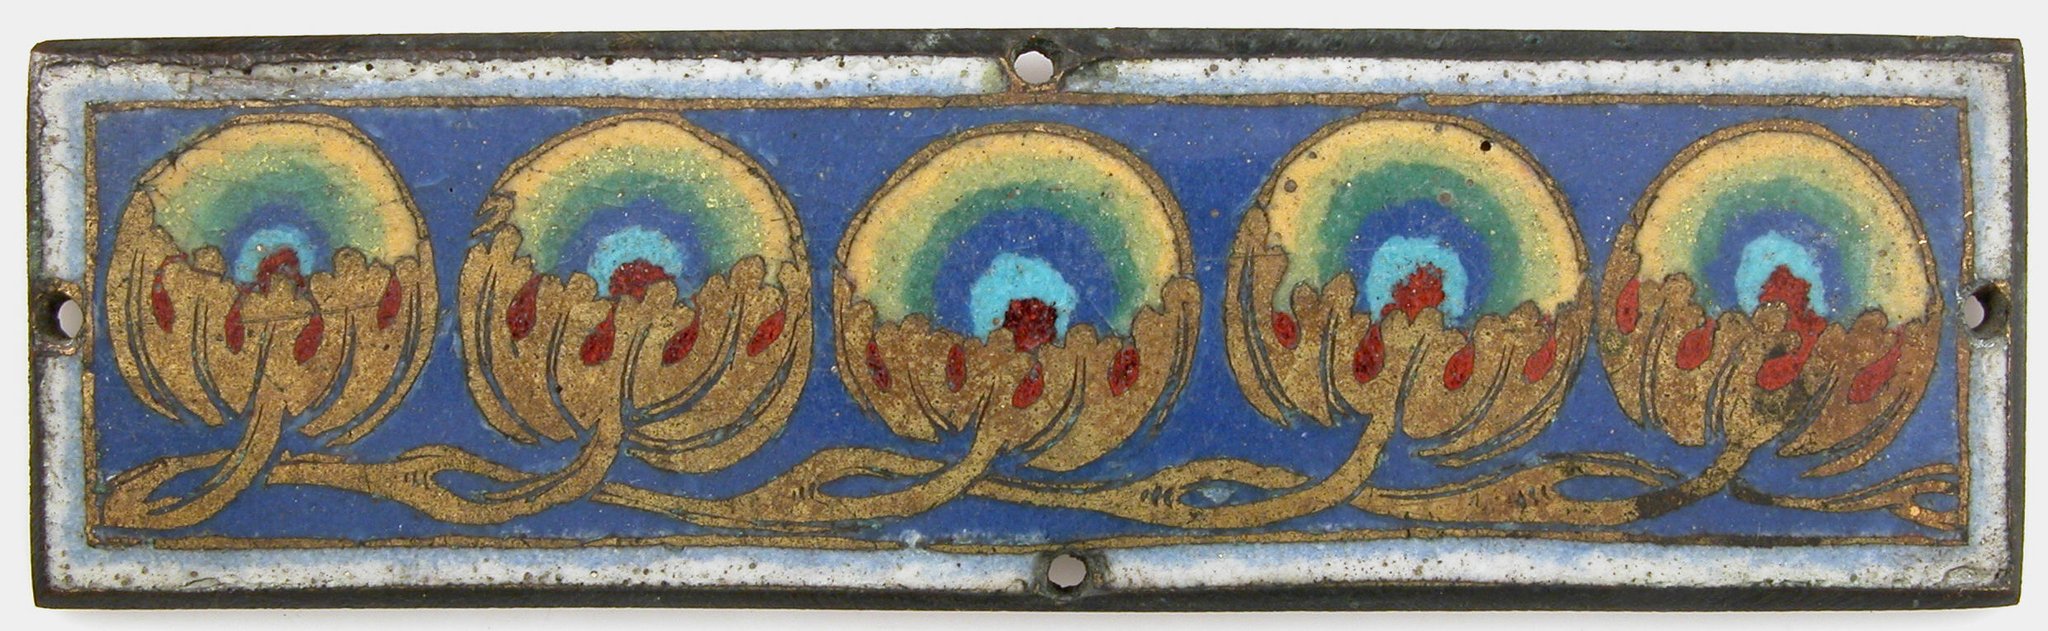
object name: plaque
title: Plaque from a Reliquary Shrine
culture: german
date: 1200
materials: copper alloy, enamel, gilt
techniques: enamel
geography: germany